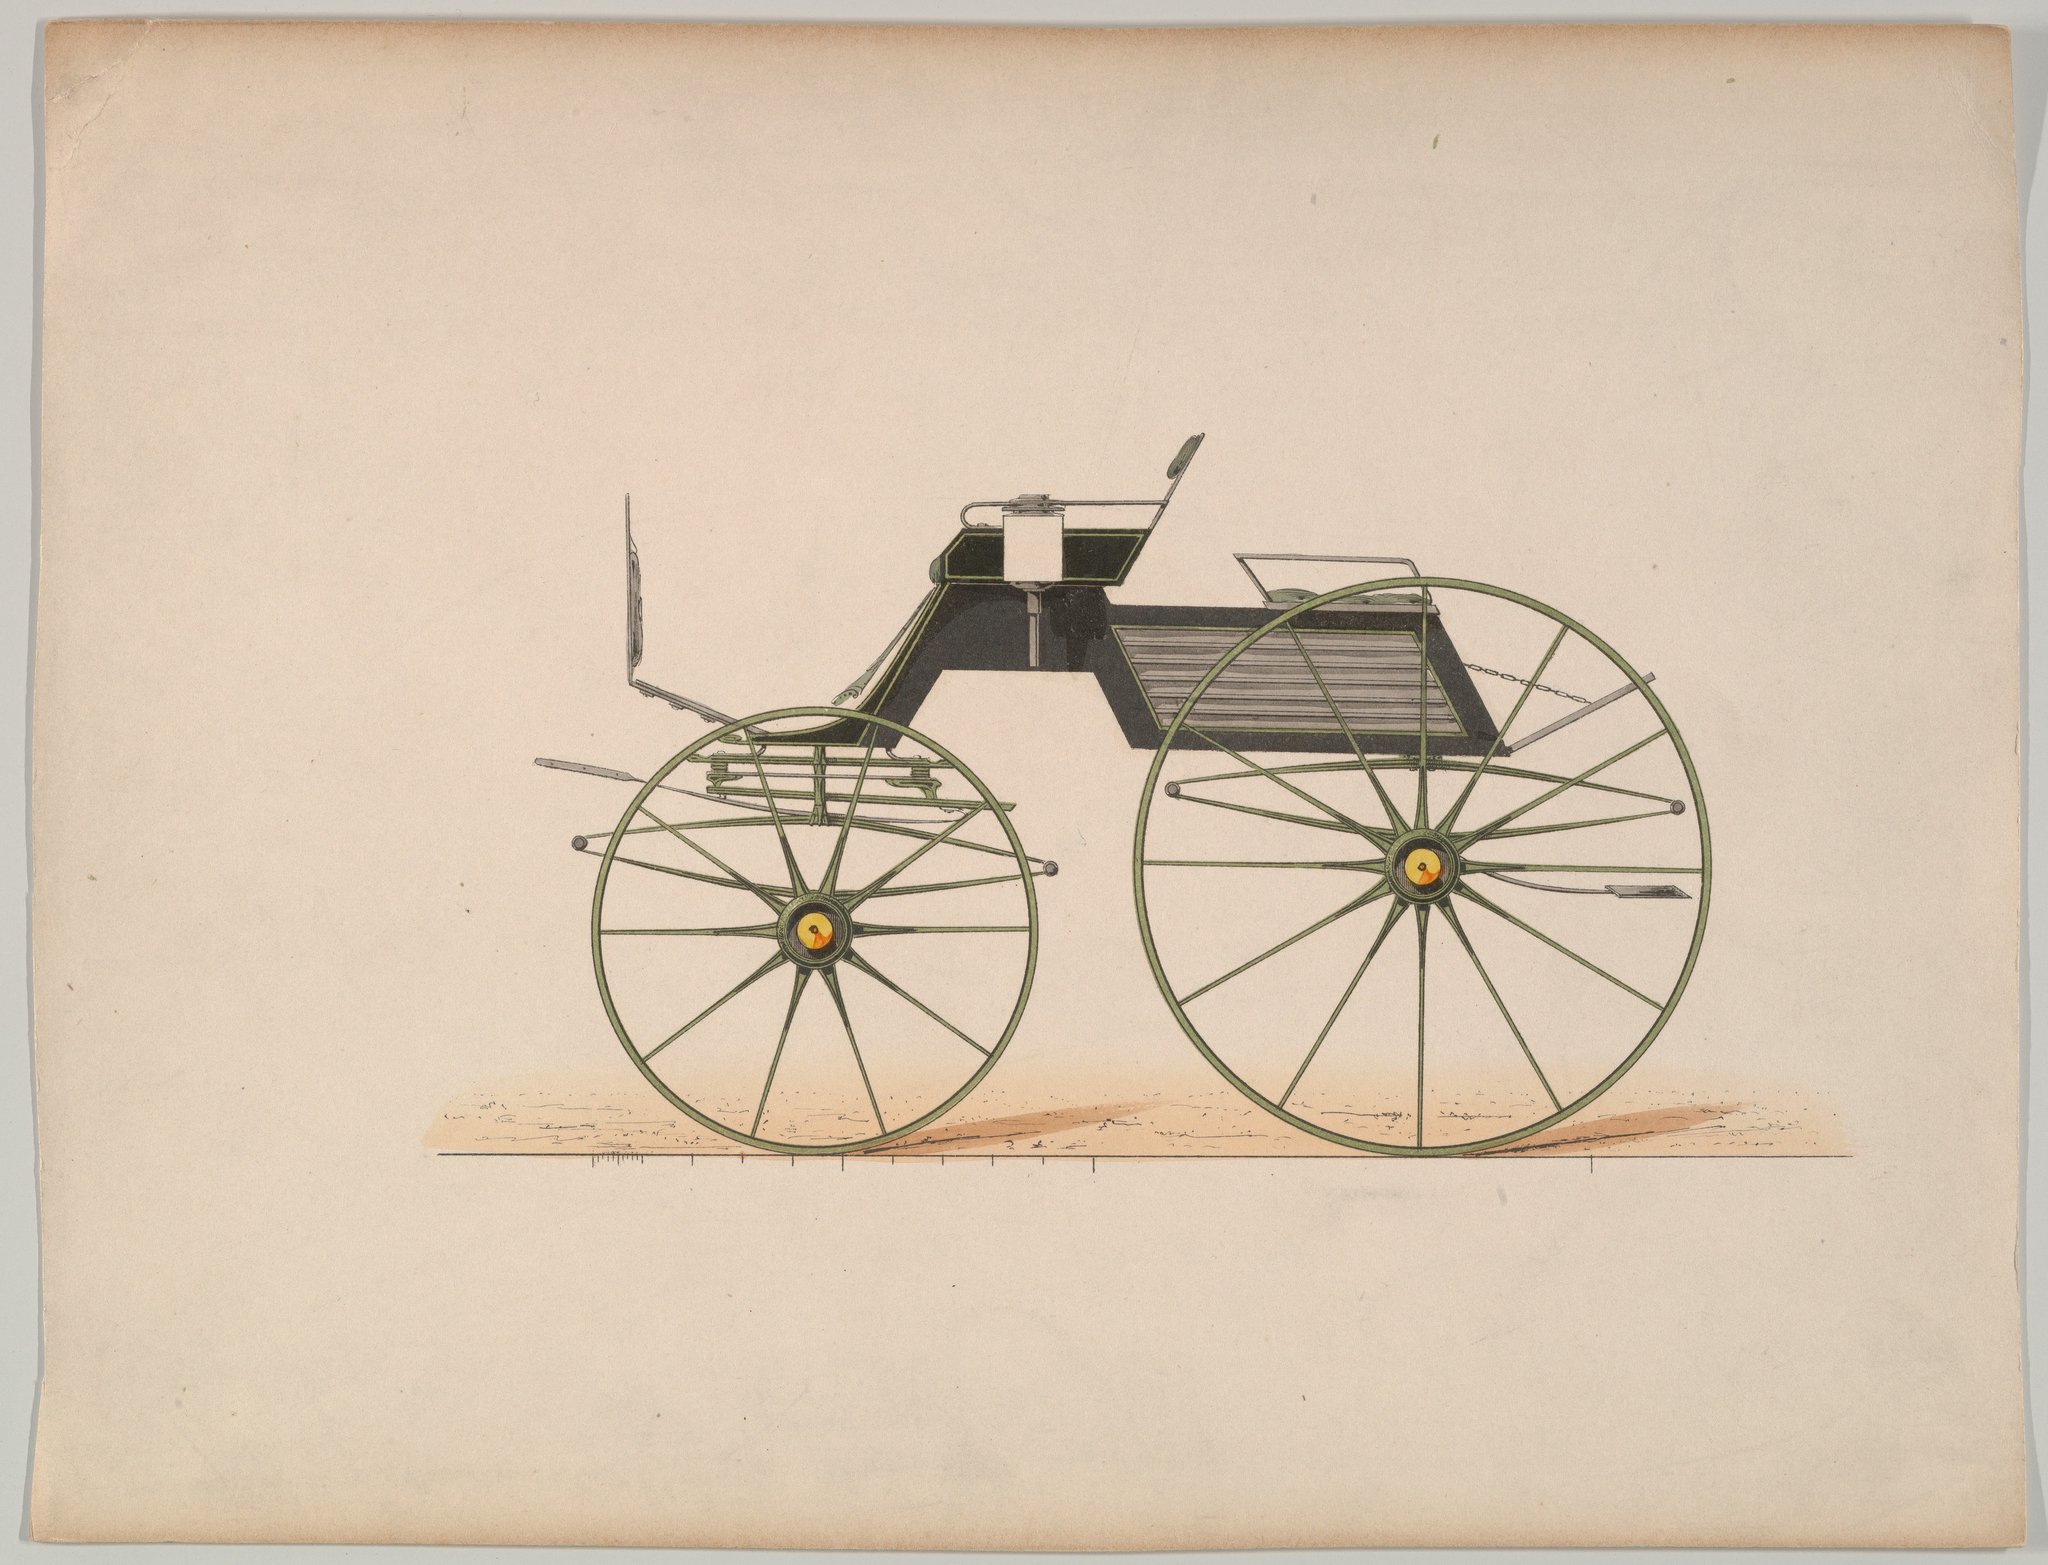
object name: drawing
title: Phaeton, no top (unnumbered)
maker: brewster & co.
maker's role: manufacturer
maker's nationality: american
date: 1850-1870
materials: gum arabic, ink, watercolor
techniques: hand coloring, pen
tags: carriages